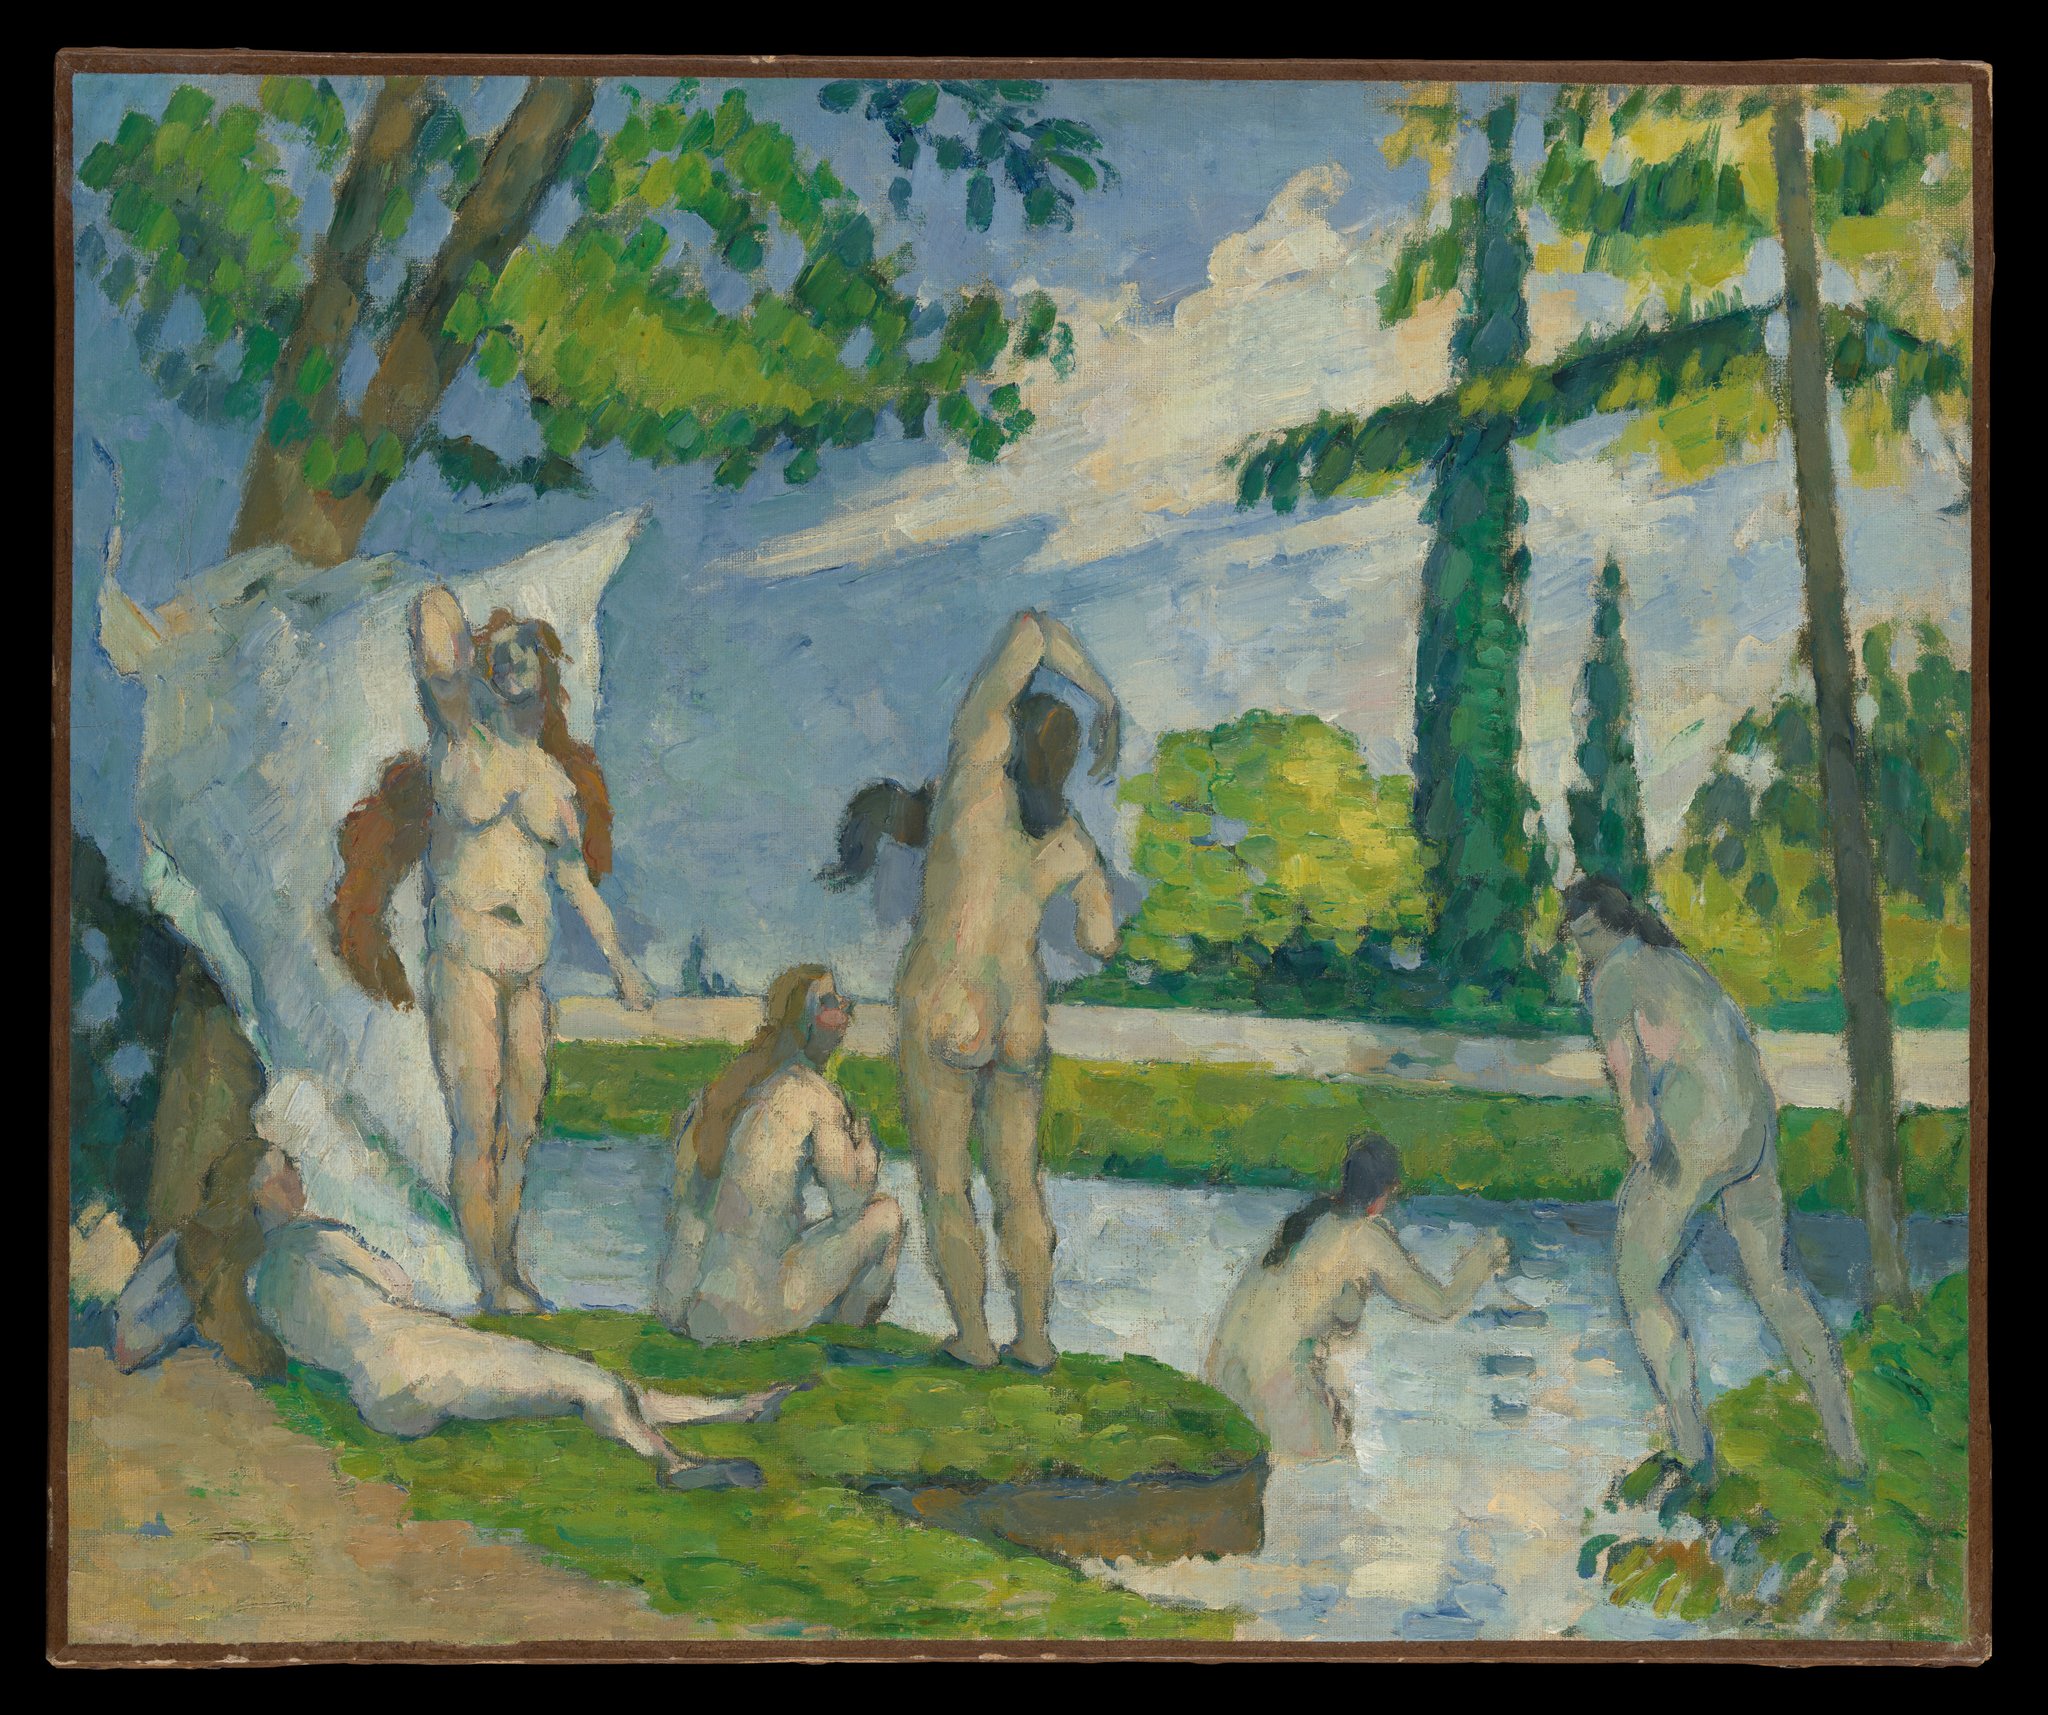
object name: painting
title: Bathers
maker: paul cézanne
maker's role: artist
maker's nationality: french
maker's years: 1839-1906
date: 1874-1875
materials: canvas, oil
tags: female nudes,bathing